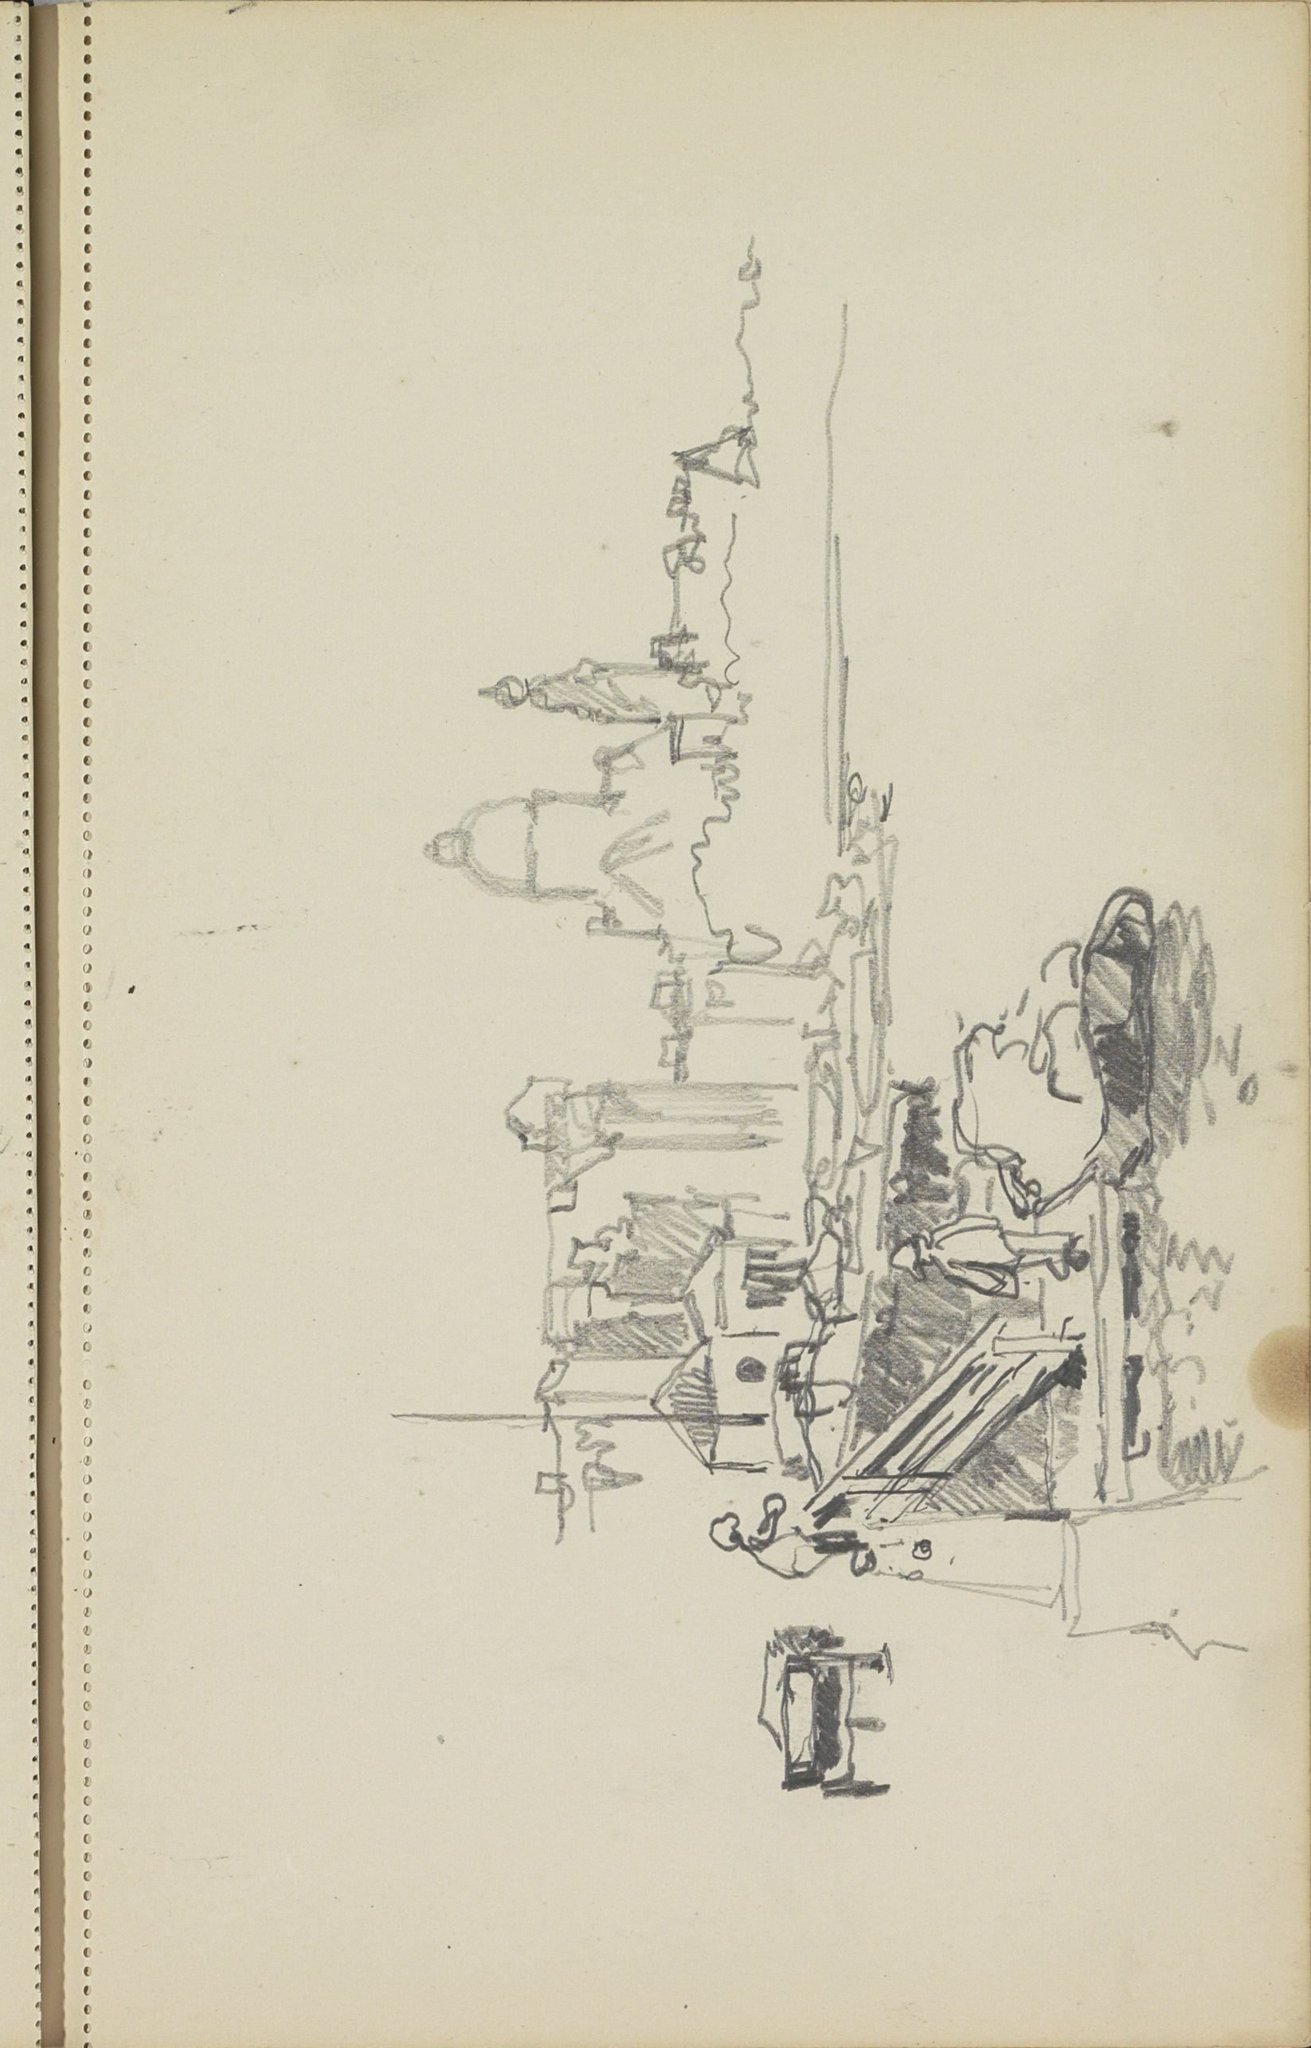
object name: sketchbook leaf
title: Aanlegplaats aan een kade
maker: cornelis vreedenburgh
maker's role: draughtsman, print maker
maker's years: 1880-1946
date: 1890-1946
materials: paper, pencil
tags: city-view, and landscape with man-made constructions, quay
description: Op de achtergrond een stadsgezicht. Blad 22 recto uit een schetsboek met 56 bladen.